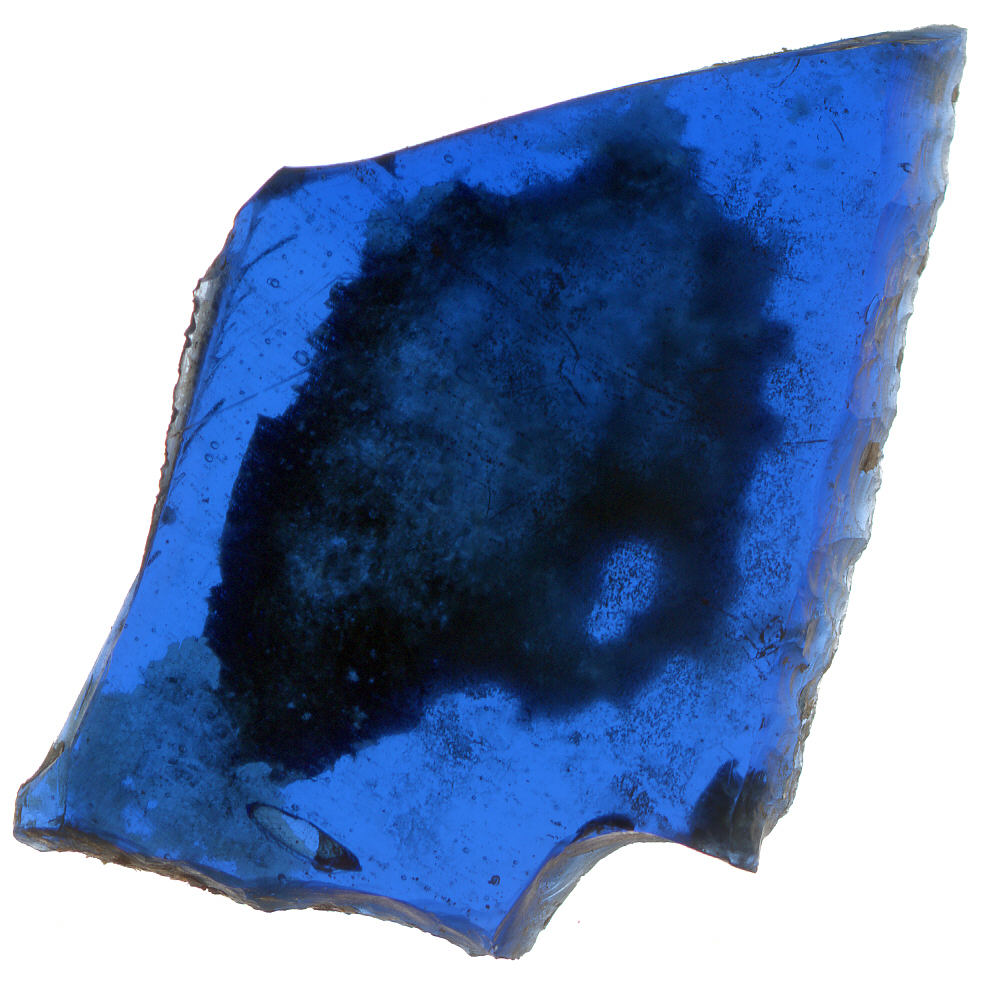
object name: fragment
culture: crusader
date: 1201-1300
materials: glass